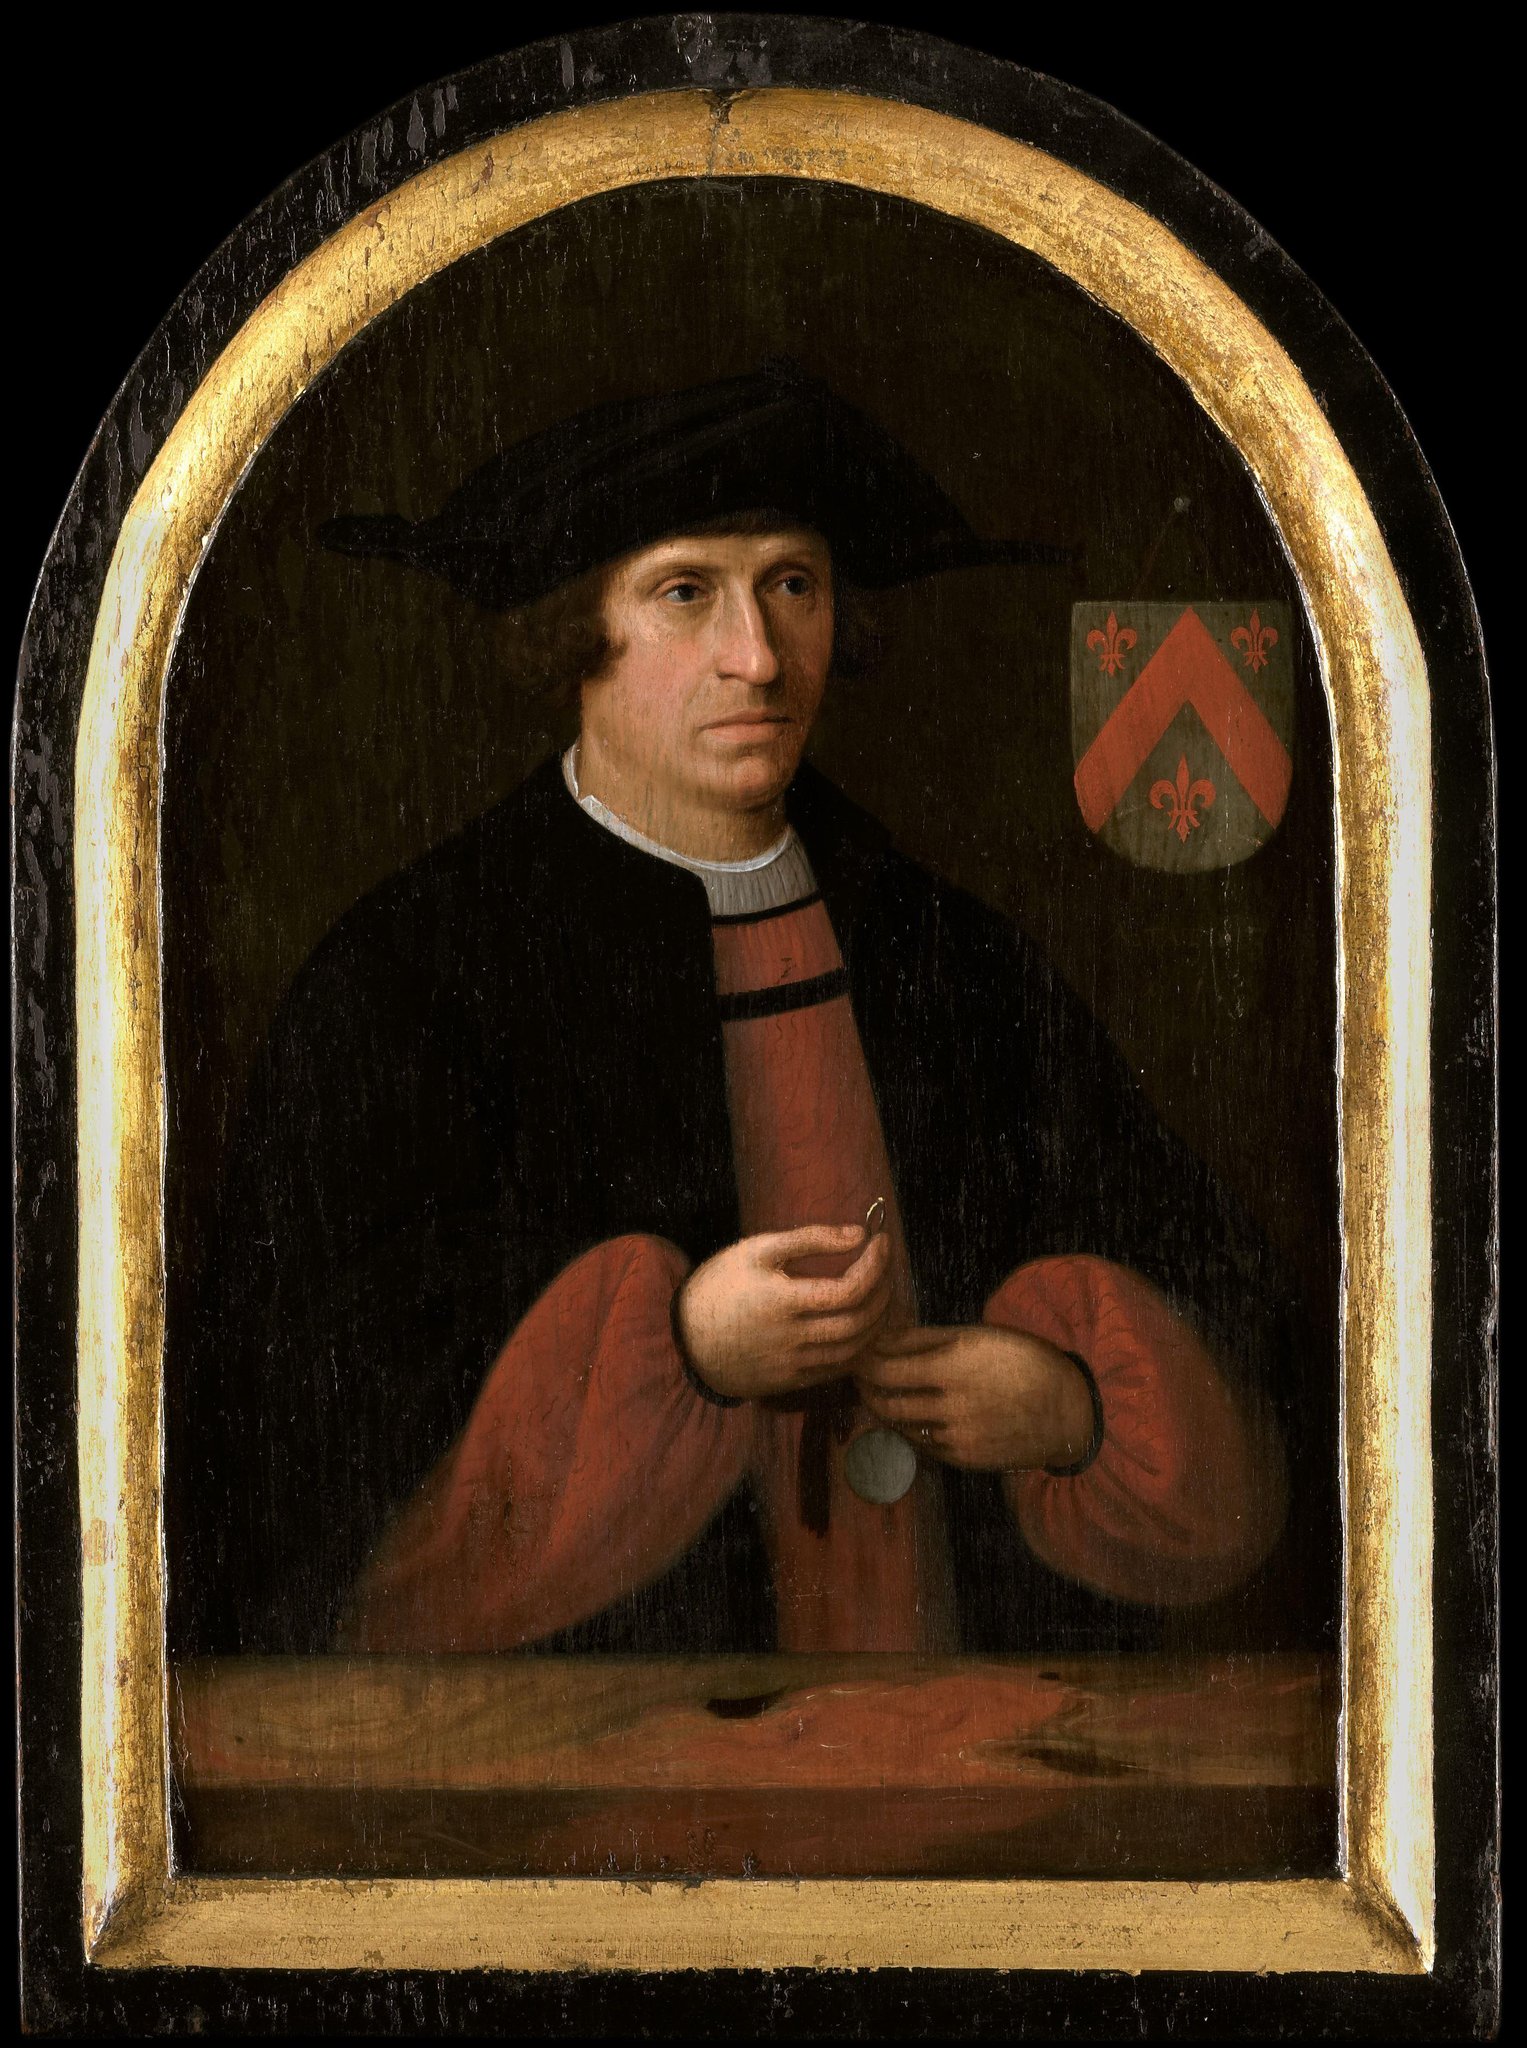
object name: painting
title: Portrait of Frans van Schoterbosch (c. 1484-?)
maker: cornelis engelsz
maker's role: painter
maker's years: 1574-1650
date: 1620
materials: oil, panel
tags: historical persons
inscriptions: coat of arms, upper right: a red chevron and three red fleurs-de-lis on a silver ground, inscription, on the reverse, in black paint: ‘1 / Frans Overyn van / Schoterbos / geb. 1484’, inscription, centre right: ‘Aet 38 An 1522’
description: Portret van Frans Overrijn van Schoterbosch (geb. ca. 1484). Ten halven lijve, staande achter een balustrade, in de rechterhand een ring. Rechtsboven het familiewapen. Misschien een kopie door Cornelis Engelsz. naar een onbekend voorbeeld uit 1522. Met geïntegreerde lijst. Behoort tot een groep portretten: SK-A-4753 / SK-A-4754 / SK-A-4776 / SK-A-4772 / SK-A-4771 / SK-A-4756 / SK-A-4757 / SK-A-4773 / SK-A-4758 / SK-A-4759 / SK-A-4775 en SK-A-4774.